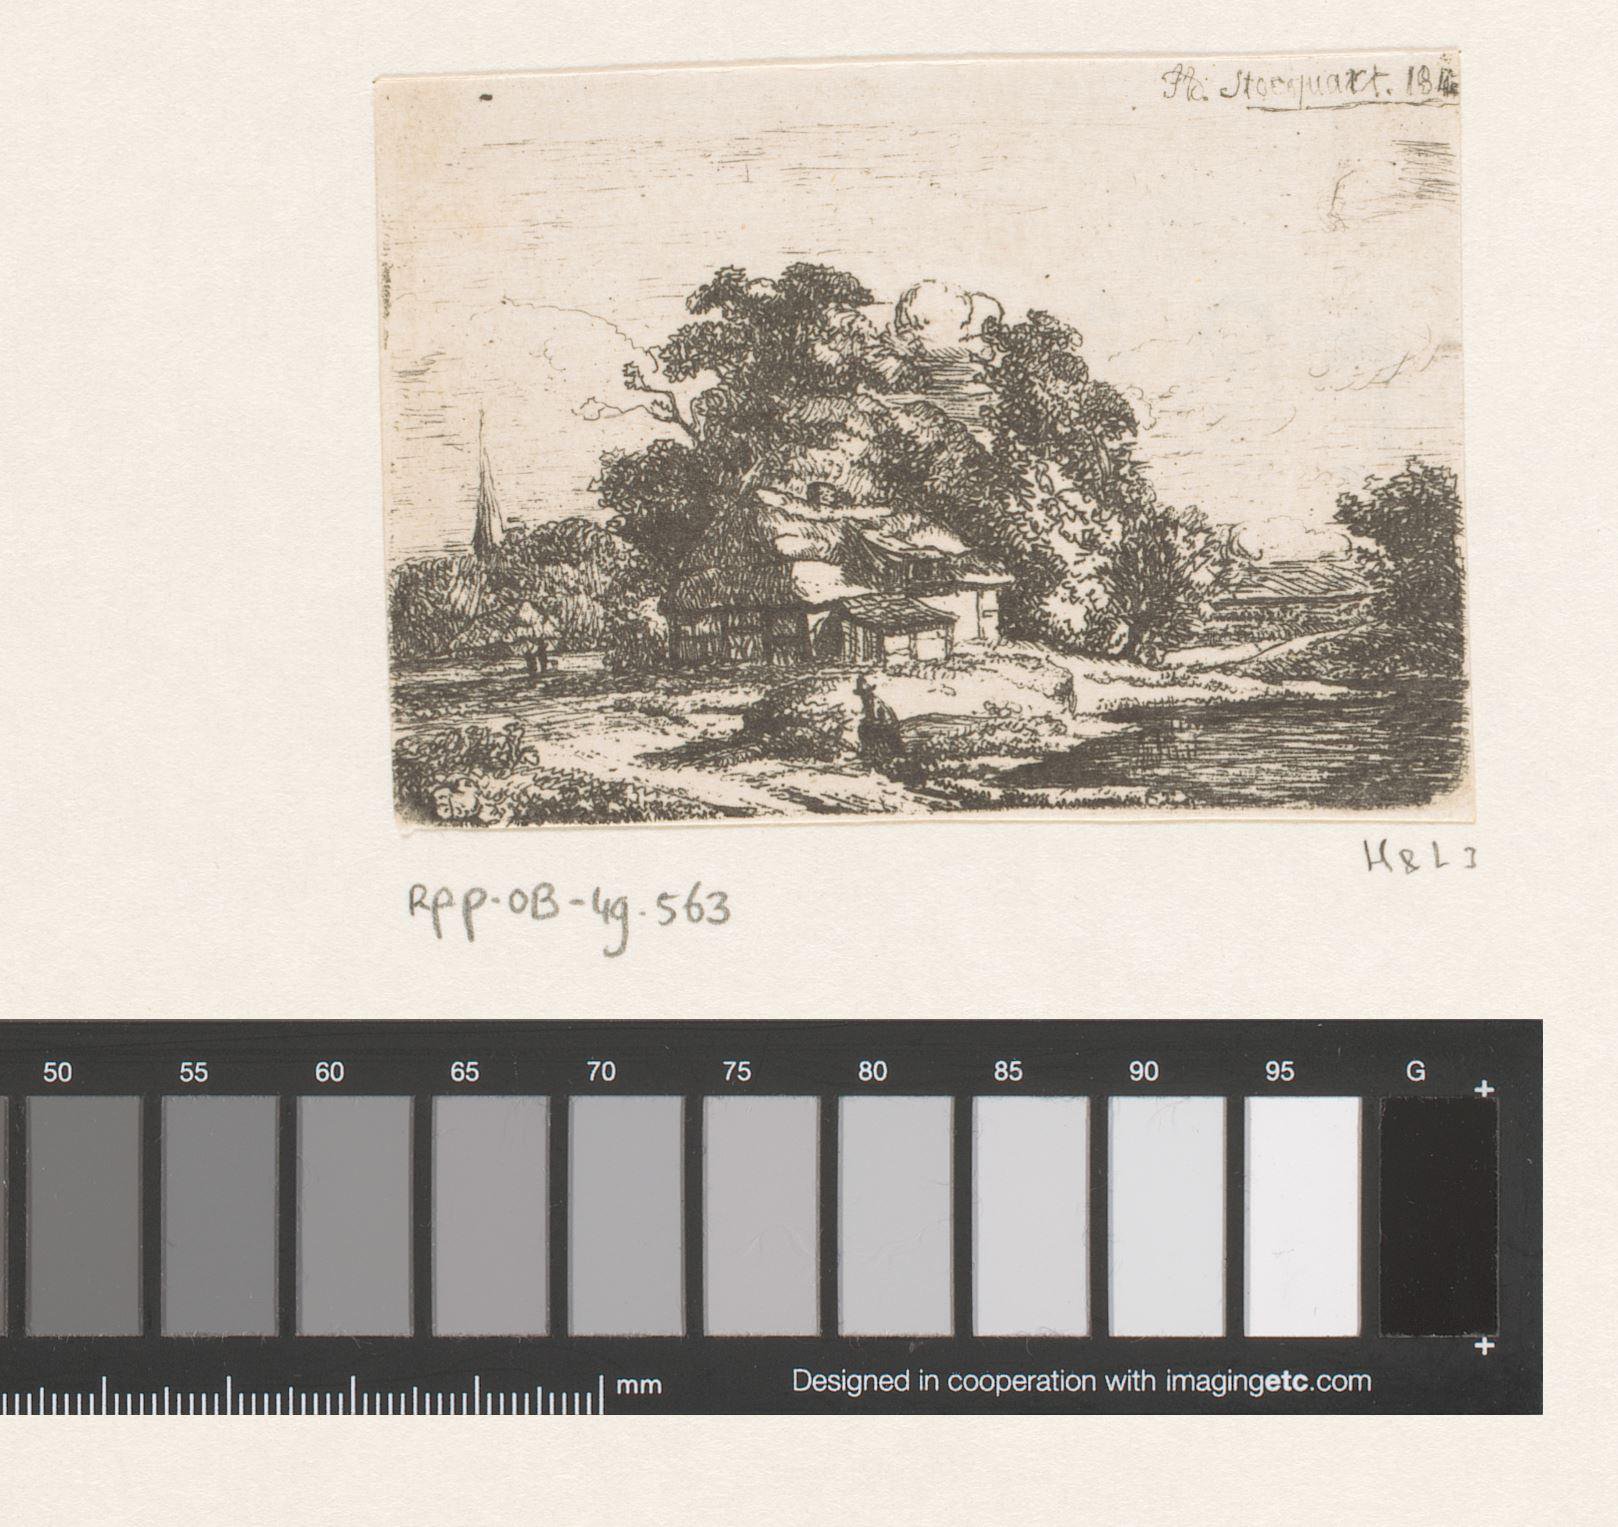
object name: print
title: Landschap met man gezeten aan het water bij een huis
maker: ildephonse stocquart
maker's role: print maker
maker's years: 1819-1889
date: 1842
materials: paper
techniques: etching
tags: landscapes (+ landscape with figures, staffage)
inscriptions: collector's mark: Lugt 2228